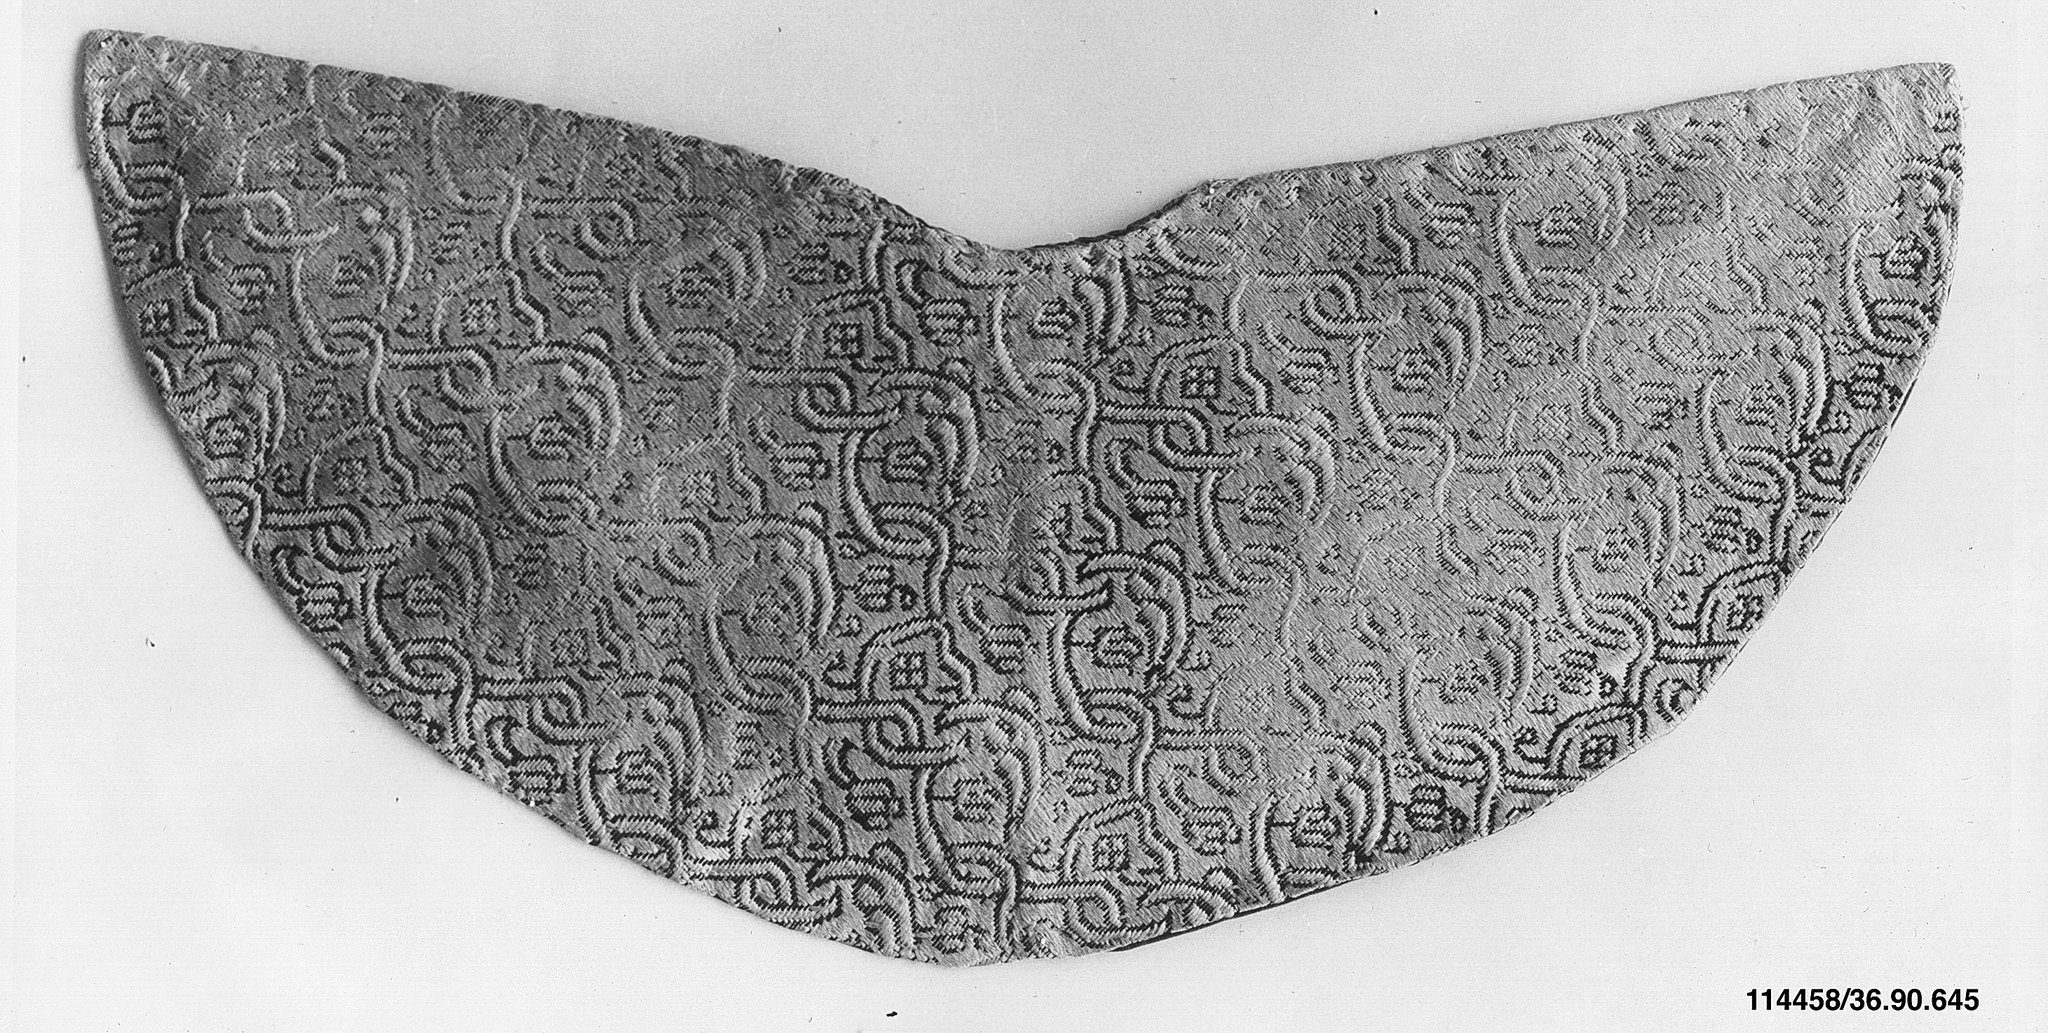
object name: piece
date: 1501-1700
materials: silk